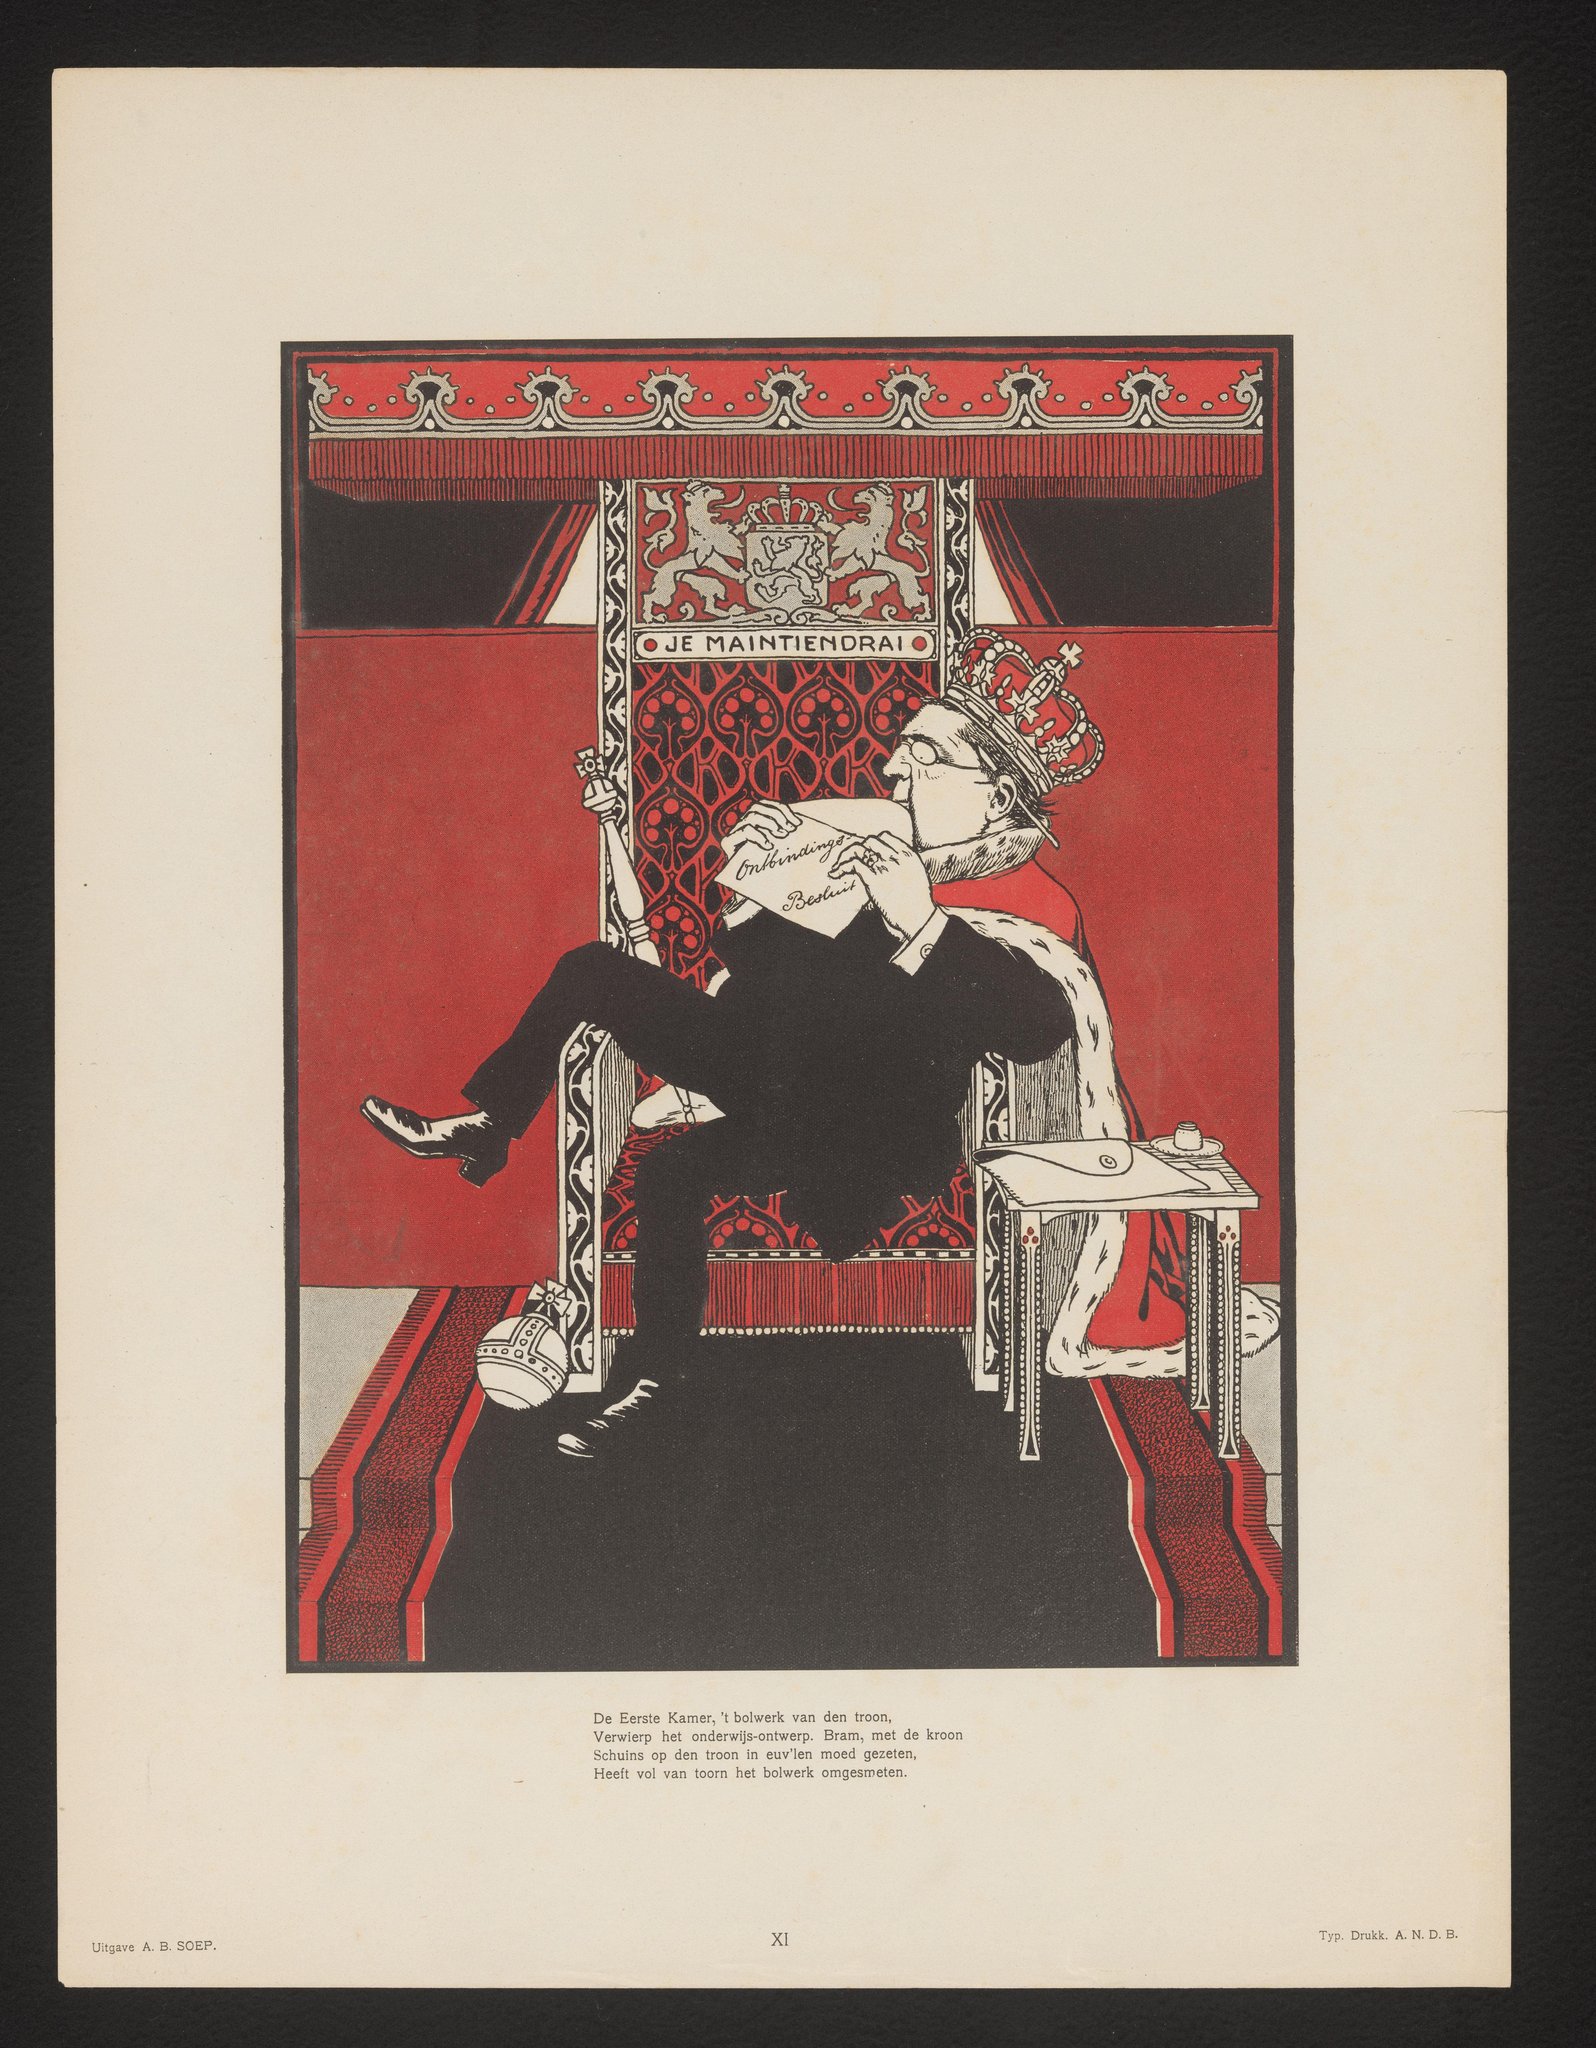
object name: print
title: Abraham Kuyper op de troon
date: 1905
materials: paper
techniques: autotype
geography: amsterdam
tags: the hague, abraham kuyper, throne, political caricatures and satires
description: Abraham Kuyper zittend als koning op de troon, na het ontbinden van de Eerste Kamer, 19 juli 1904. Met vierregelig onderschrift. Onderdeel van de prentserie 'Onder Zwart Regime'.